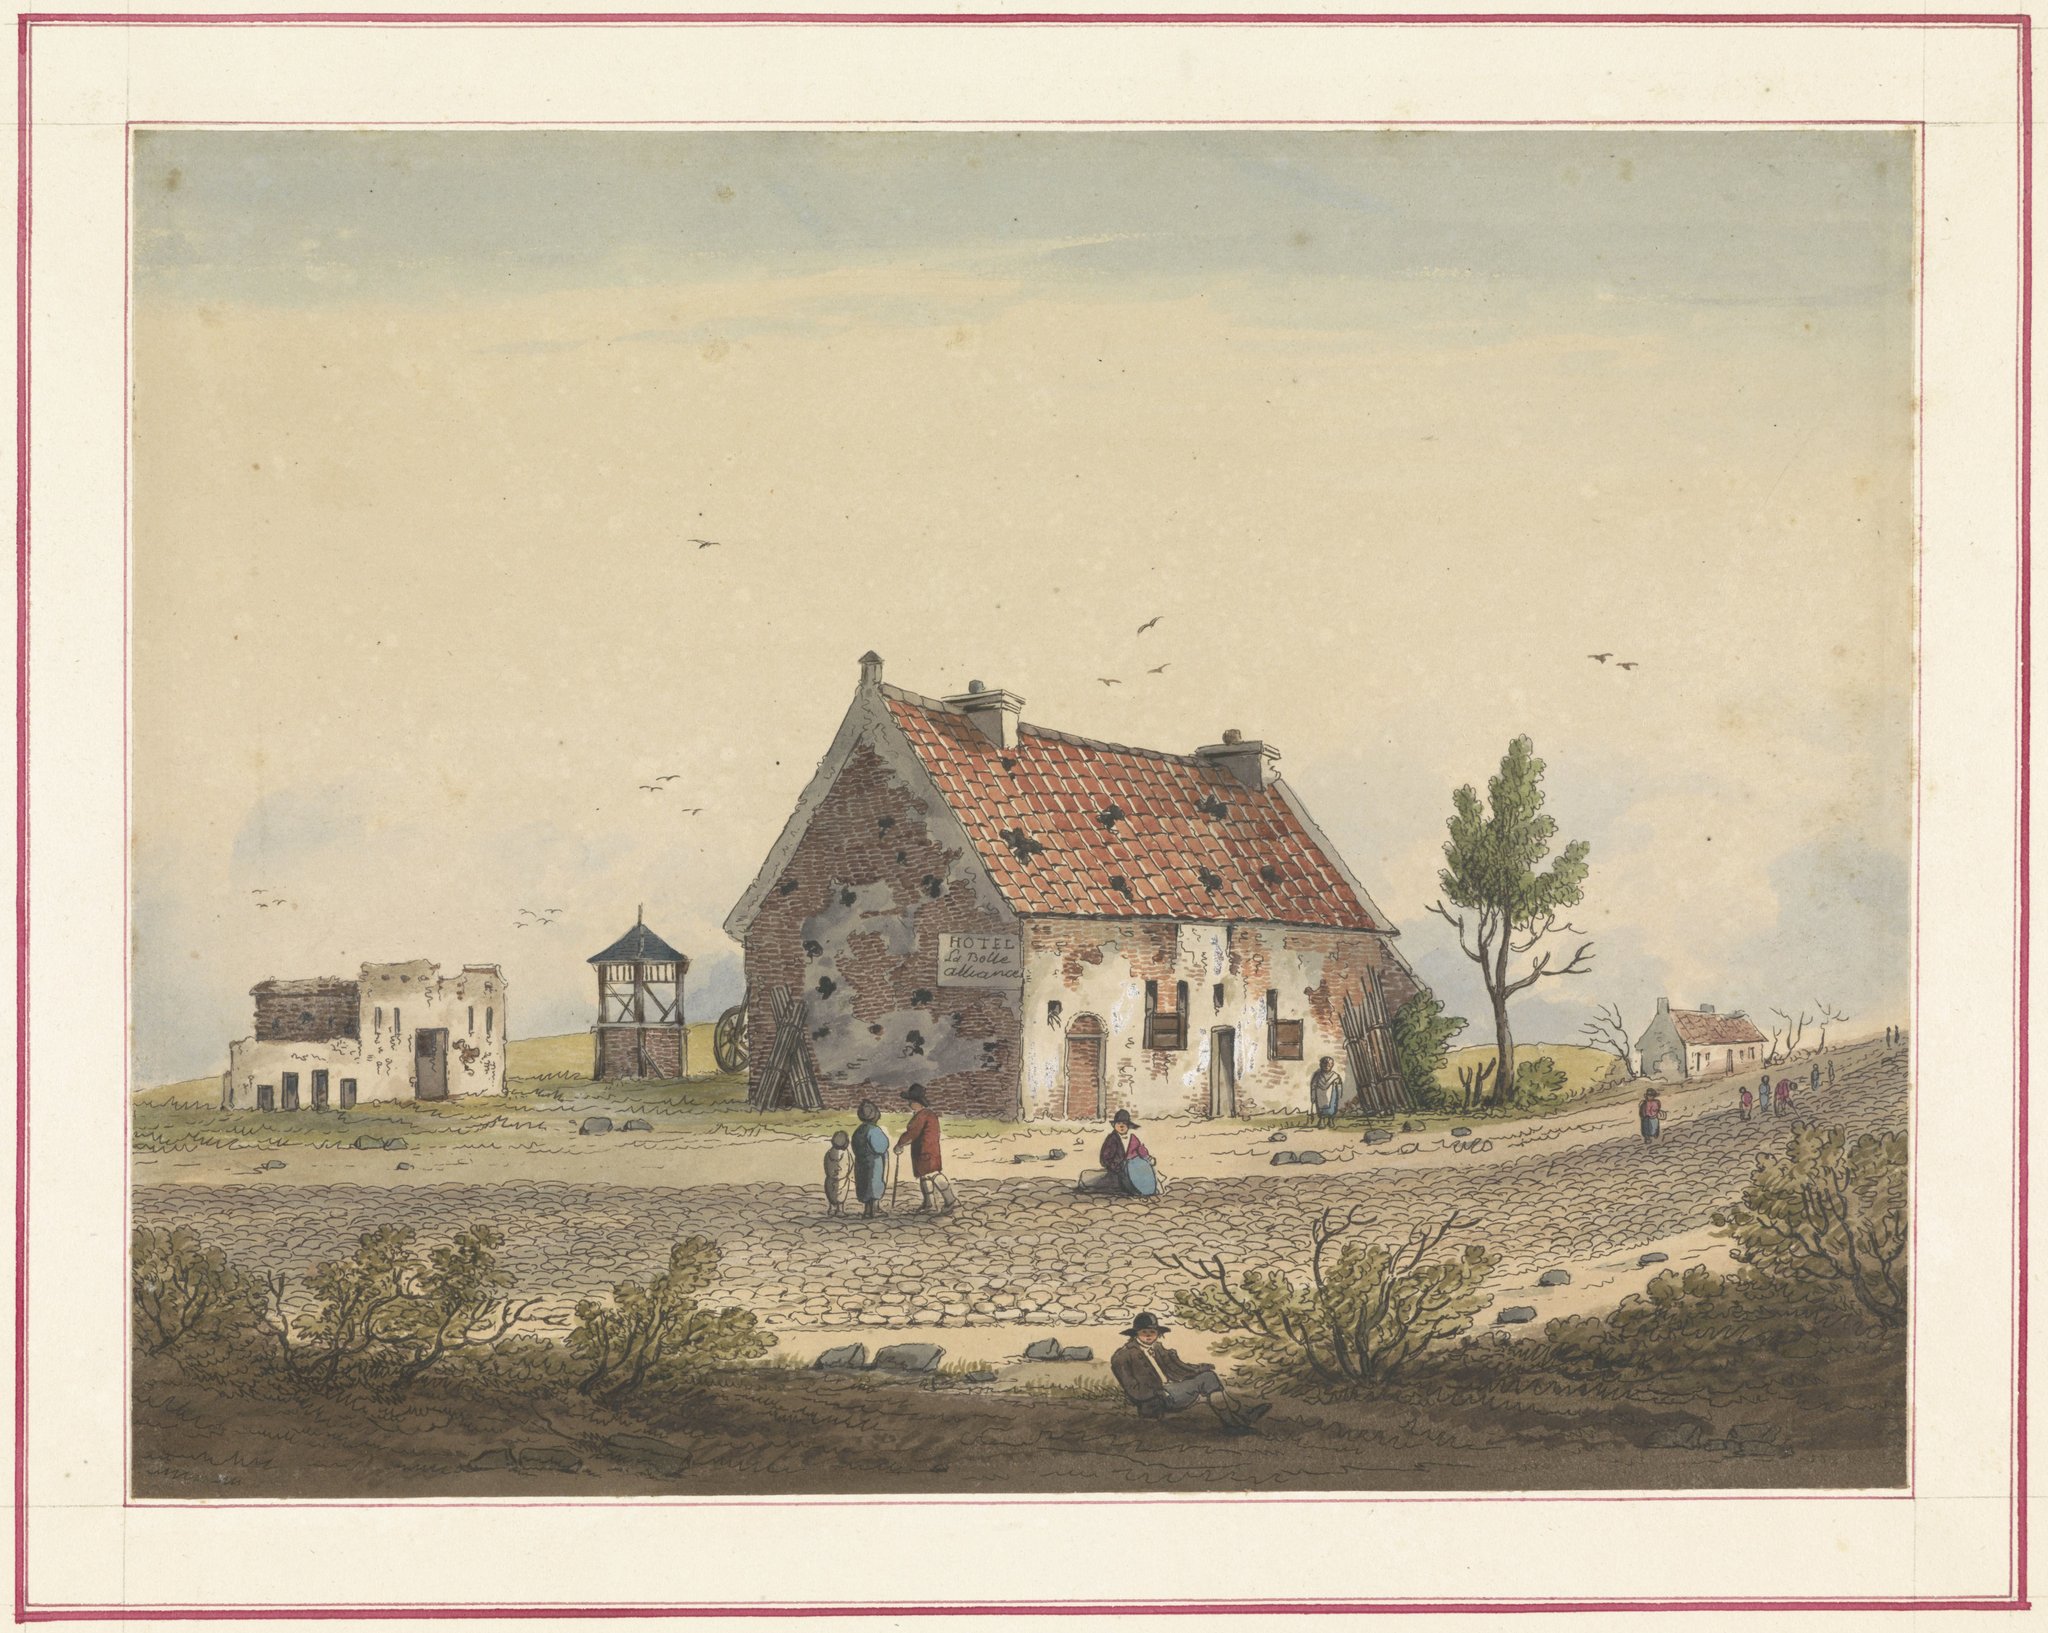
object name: print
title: Zeven platen van Waterloo en omgeving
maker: Anonymous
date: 1815-1825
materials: paper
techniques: etching, hand coloring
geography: low countries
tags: devastated, ruined place or city (~ warfare), farm (building), waterloo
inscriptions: collector's mark: Lugt 2228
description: Hotel La Belle Alliance, met kogelgaten in de muren en dak. Onderdeel van een serie van zeven platen met gezichten uit ca. 1820 van de omgeving waar de slag bij Waterloo plaatsvond op 18 juni 1815.